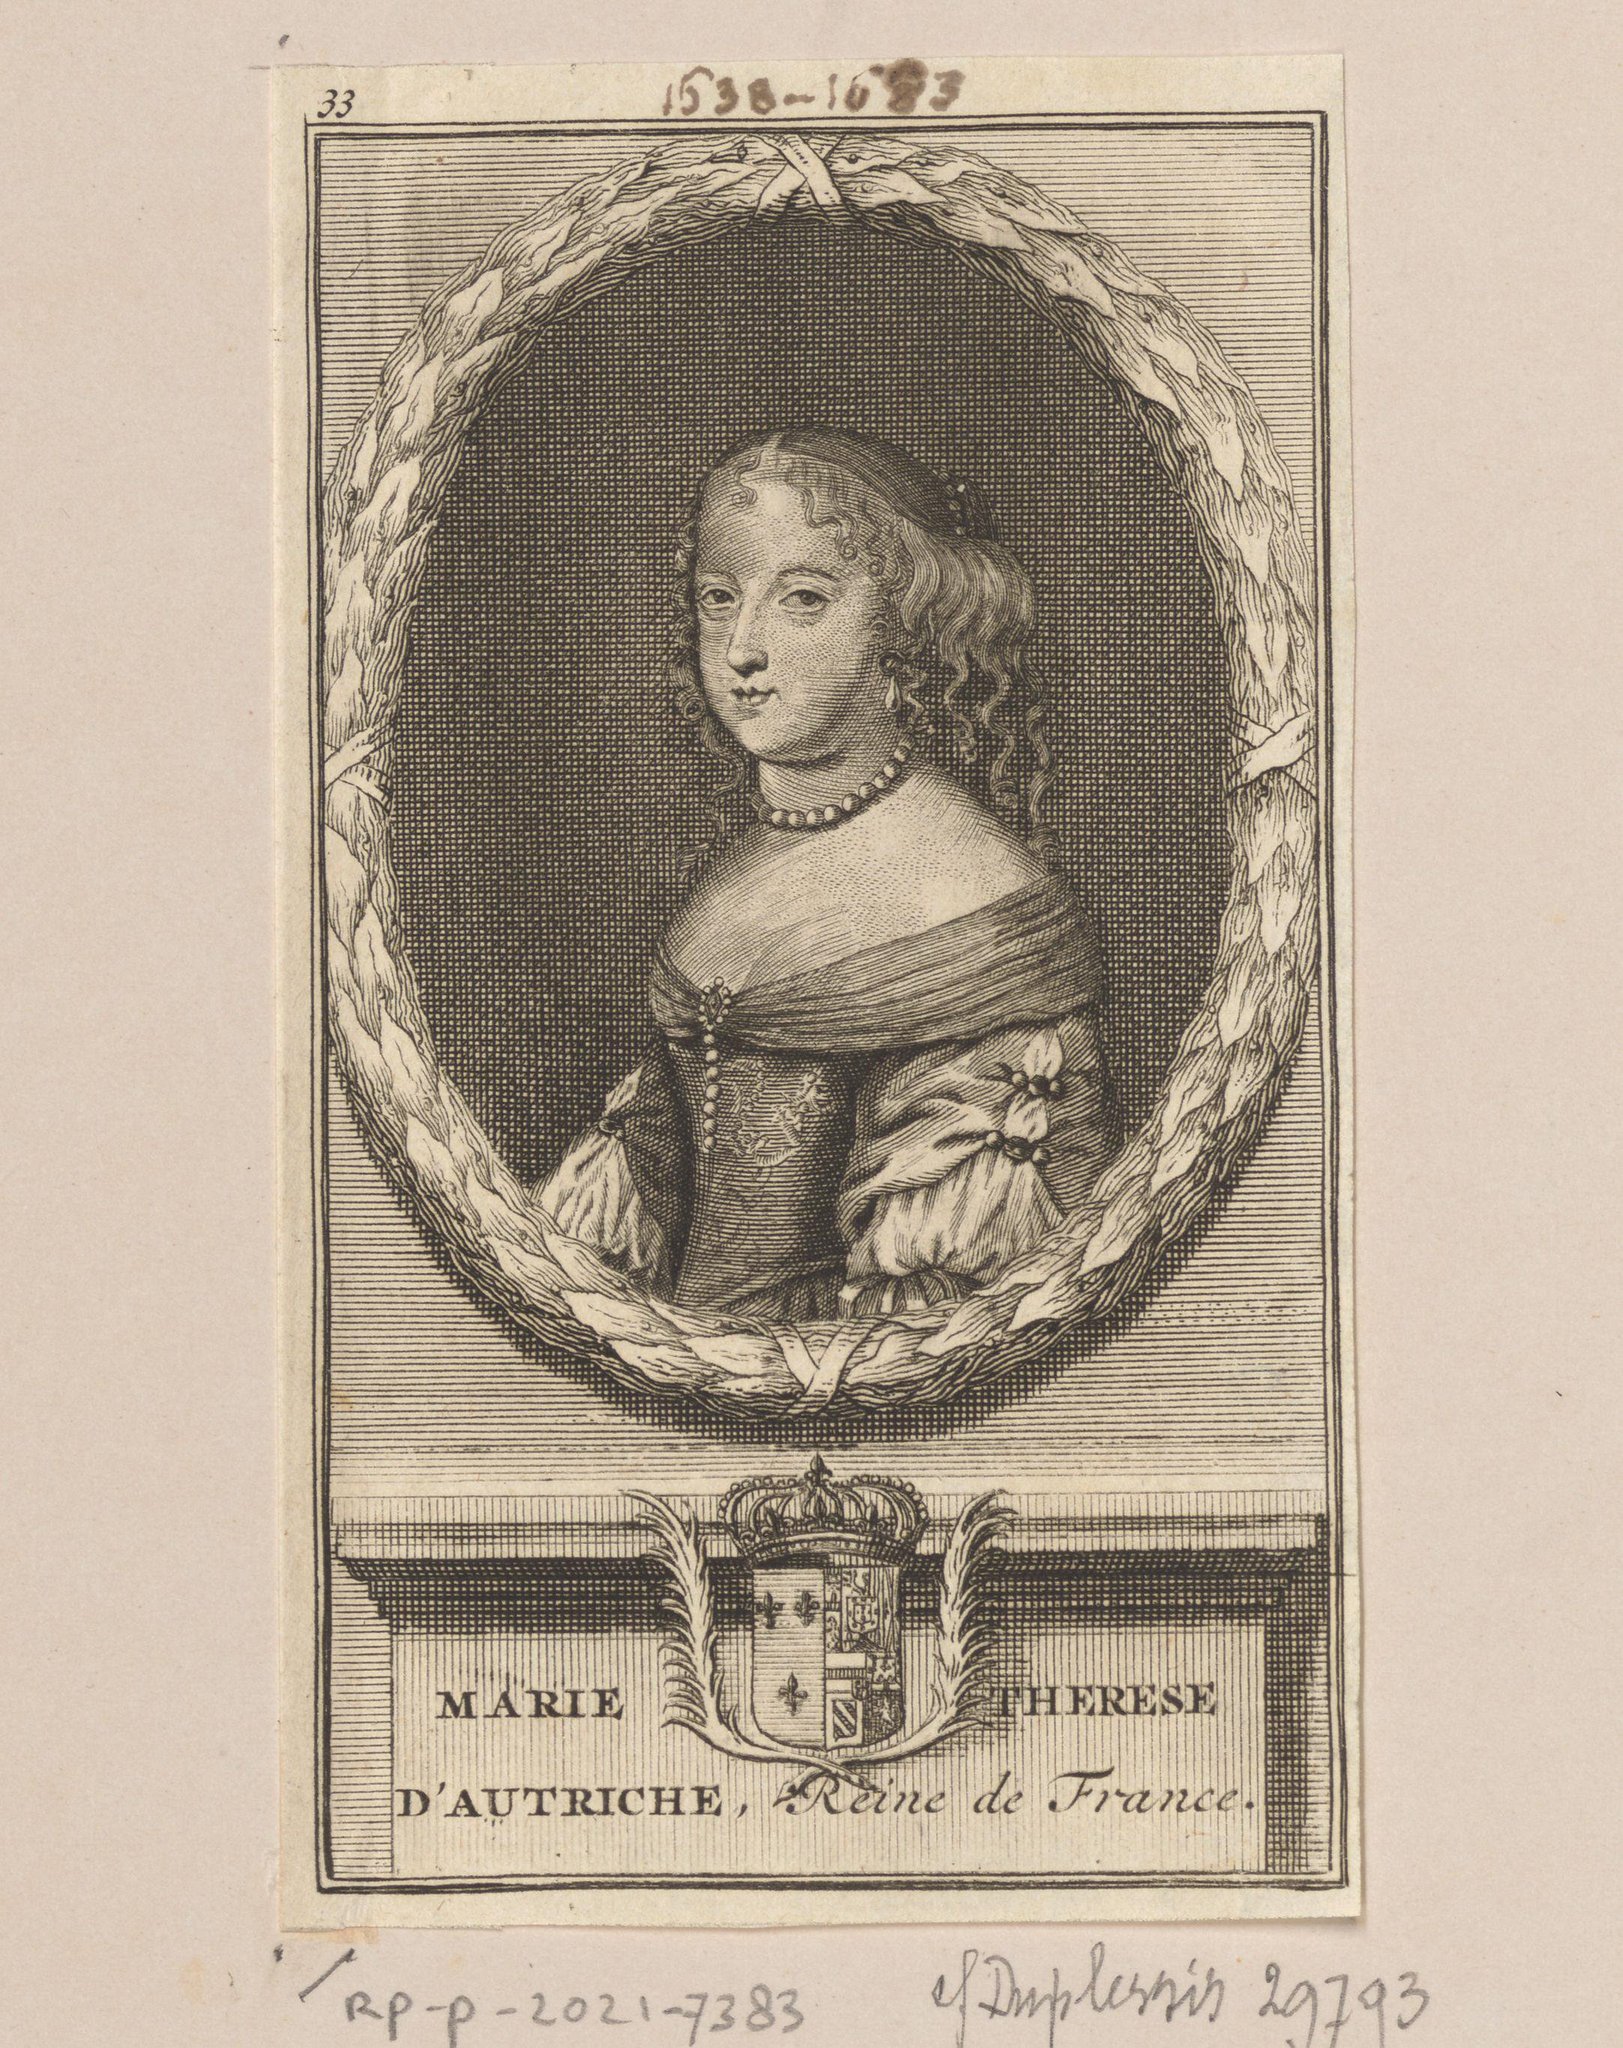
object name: print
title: Portret van Maria Theresia van Oostenrijk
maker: Anonymous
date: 1660-1699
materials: paper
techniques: engraving, etching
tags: maria theresia (koningin van frankrijk), historical persons - bb - woman, ornament ~ medallion, queen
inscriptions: inscription: ‘1638-1683’